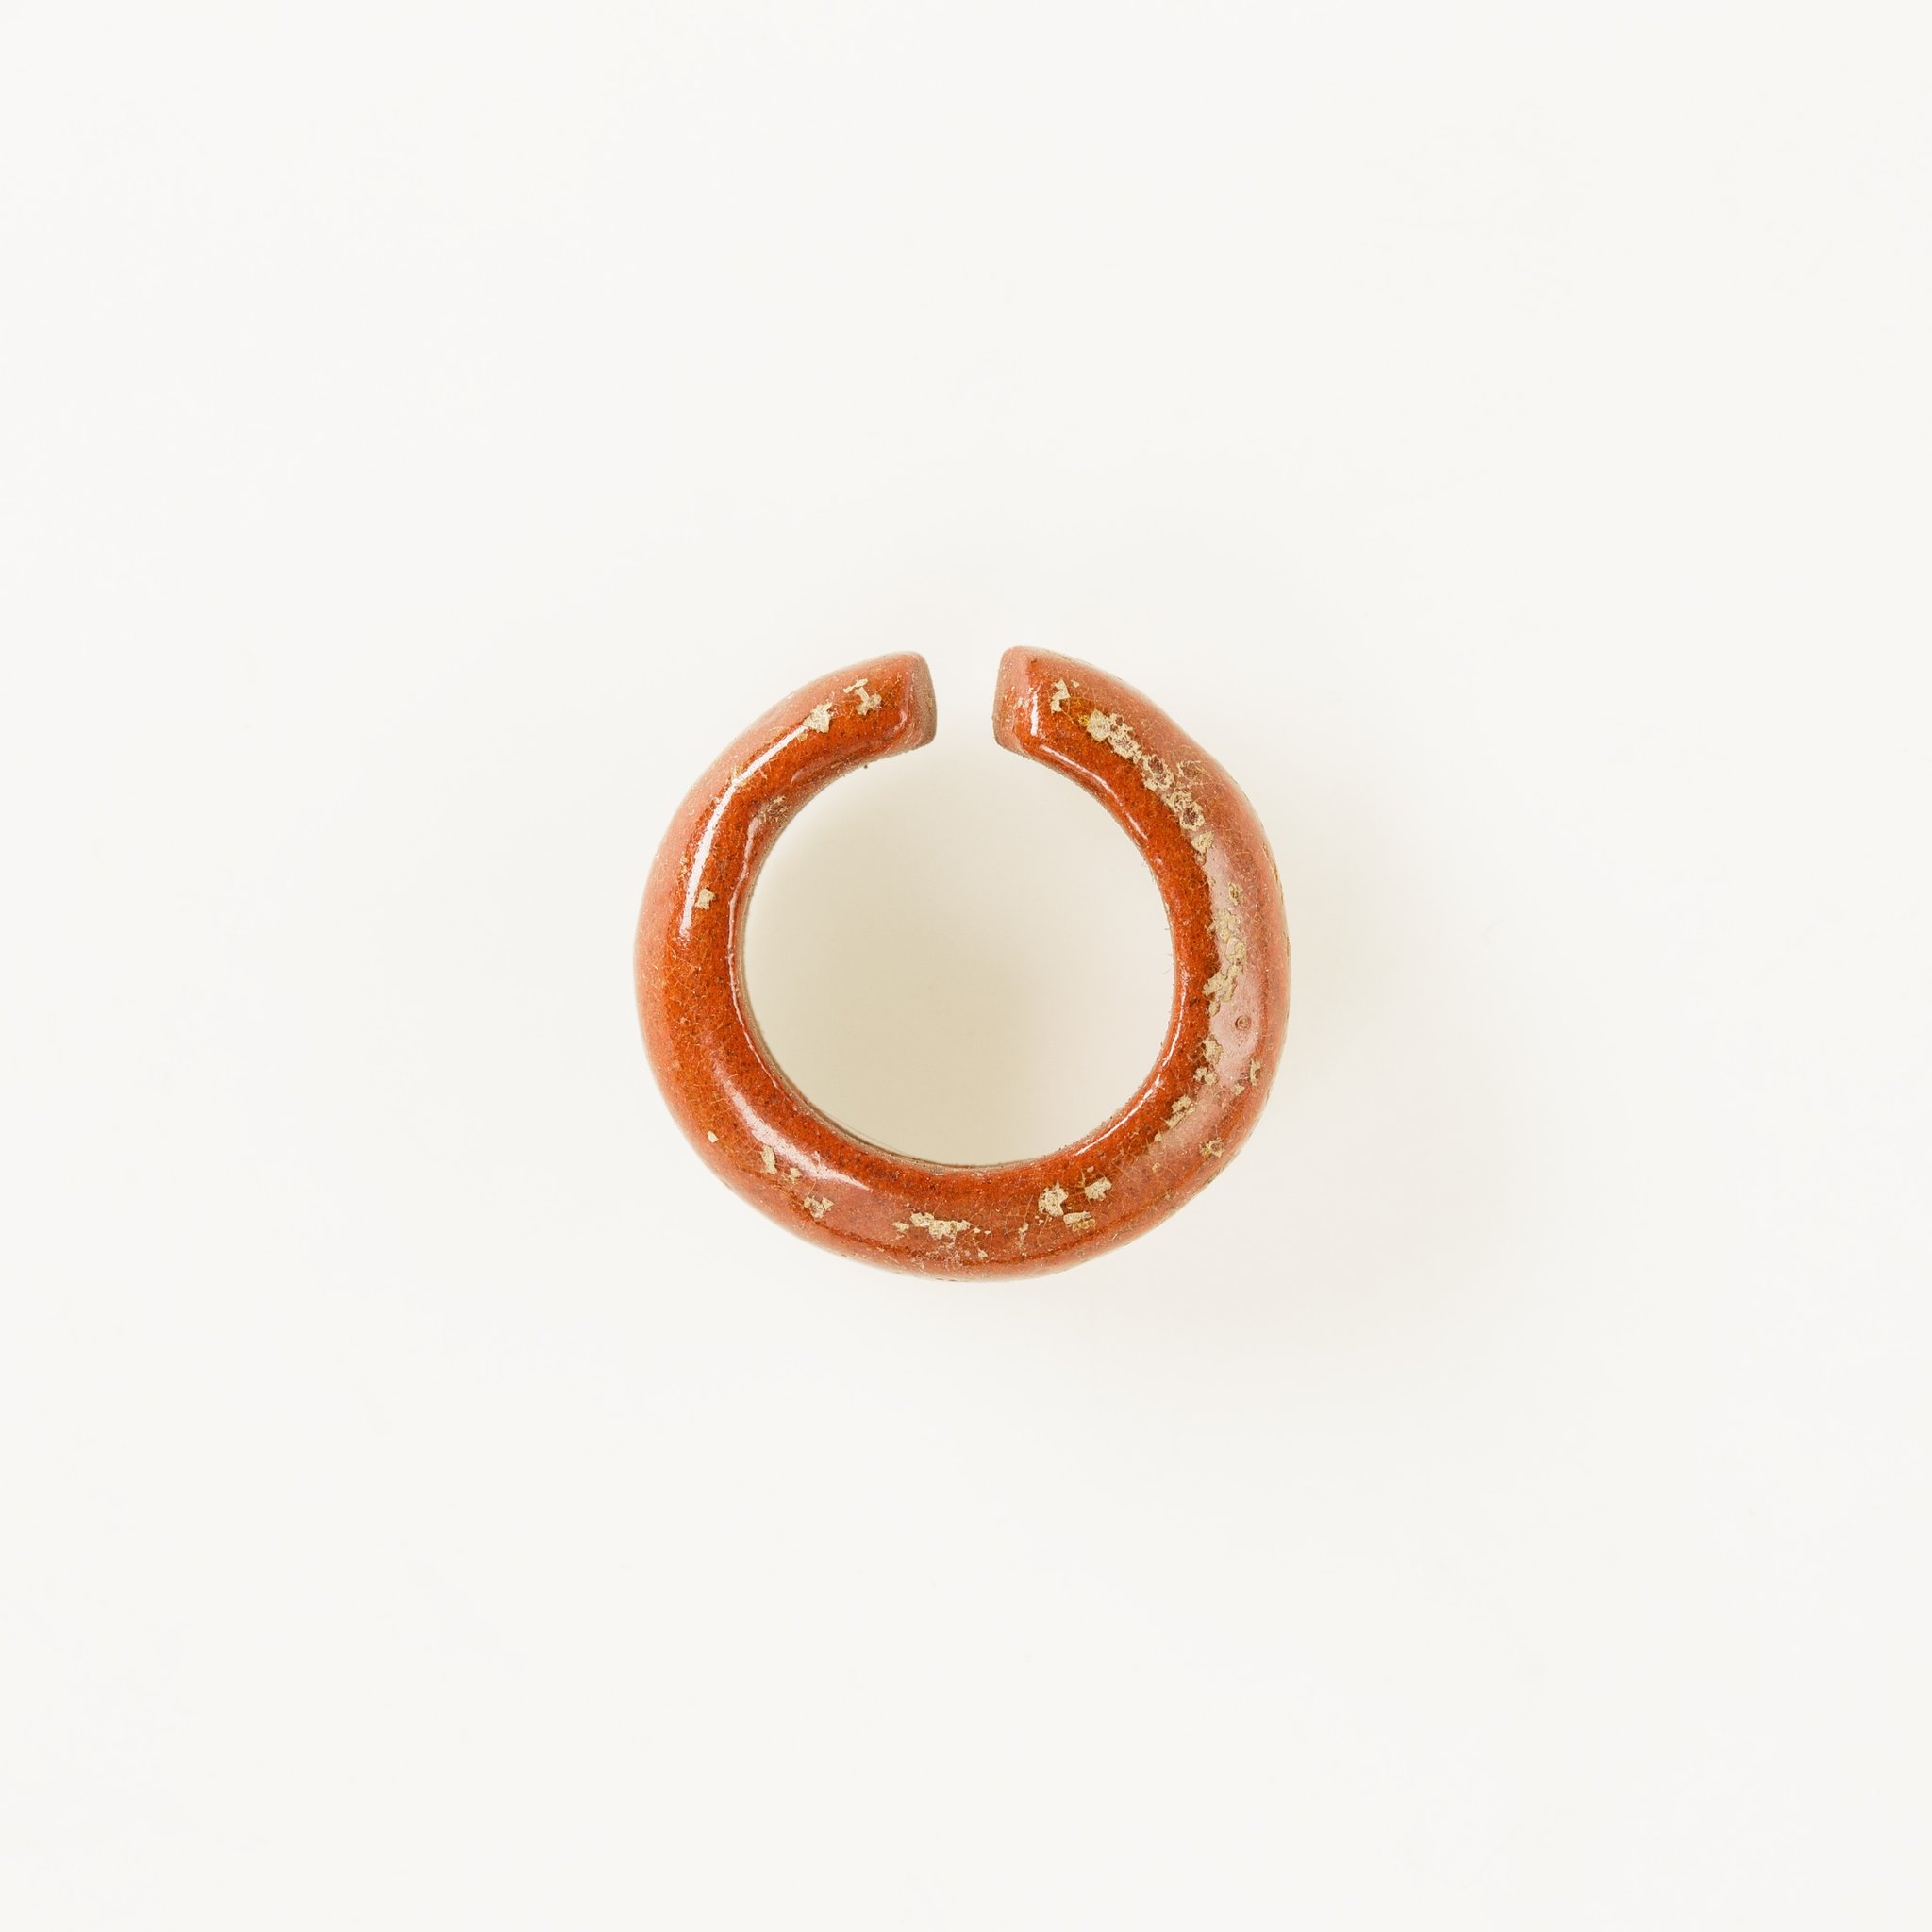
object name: hair ring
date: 1070-343 BCE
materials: faience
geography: egypt